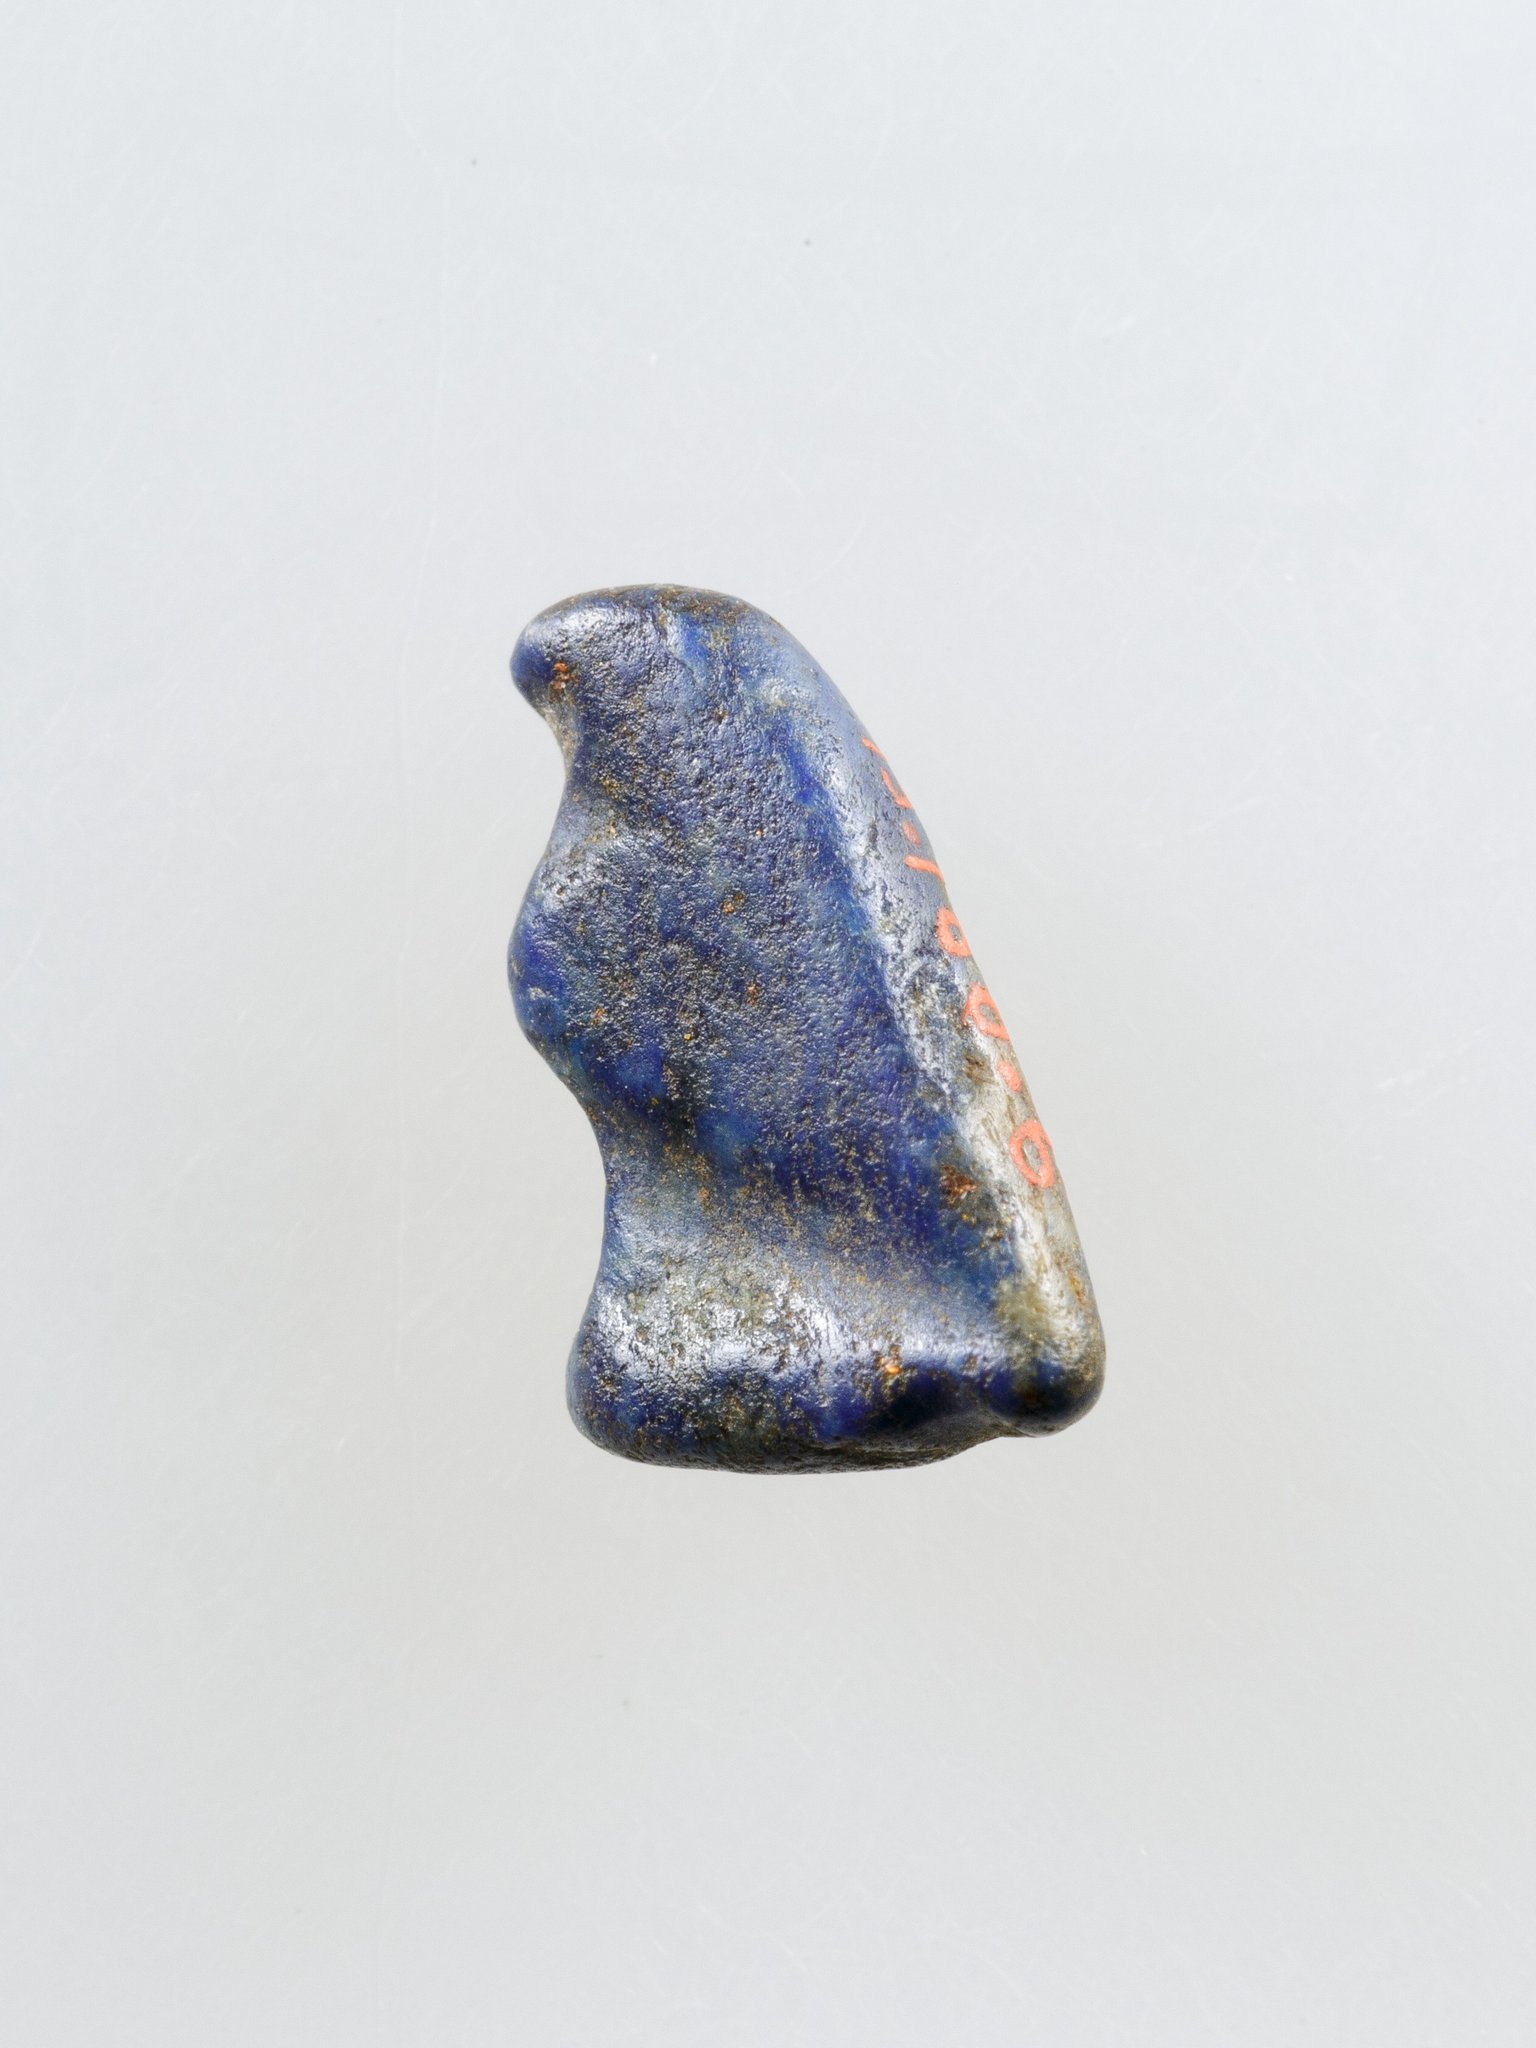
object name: amulet, falcon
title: Falcon Amulet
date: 1850-1700 BCE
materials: lapis lazuli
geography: egypt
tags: falcons